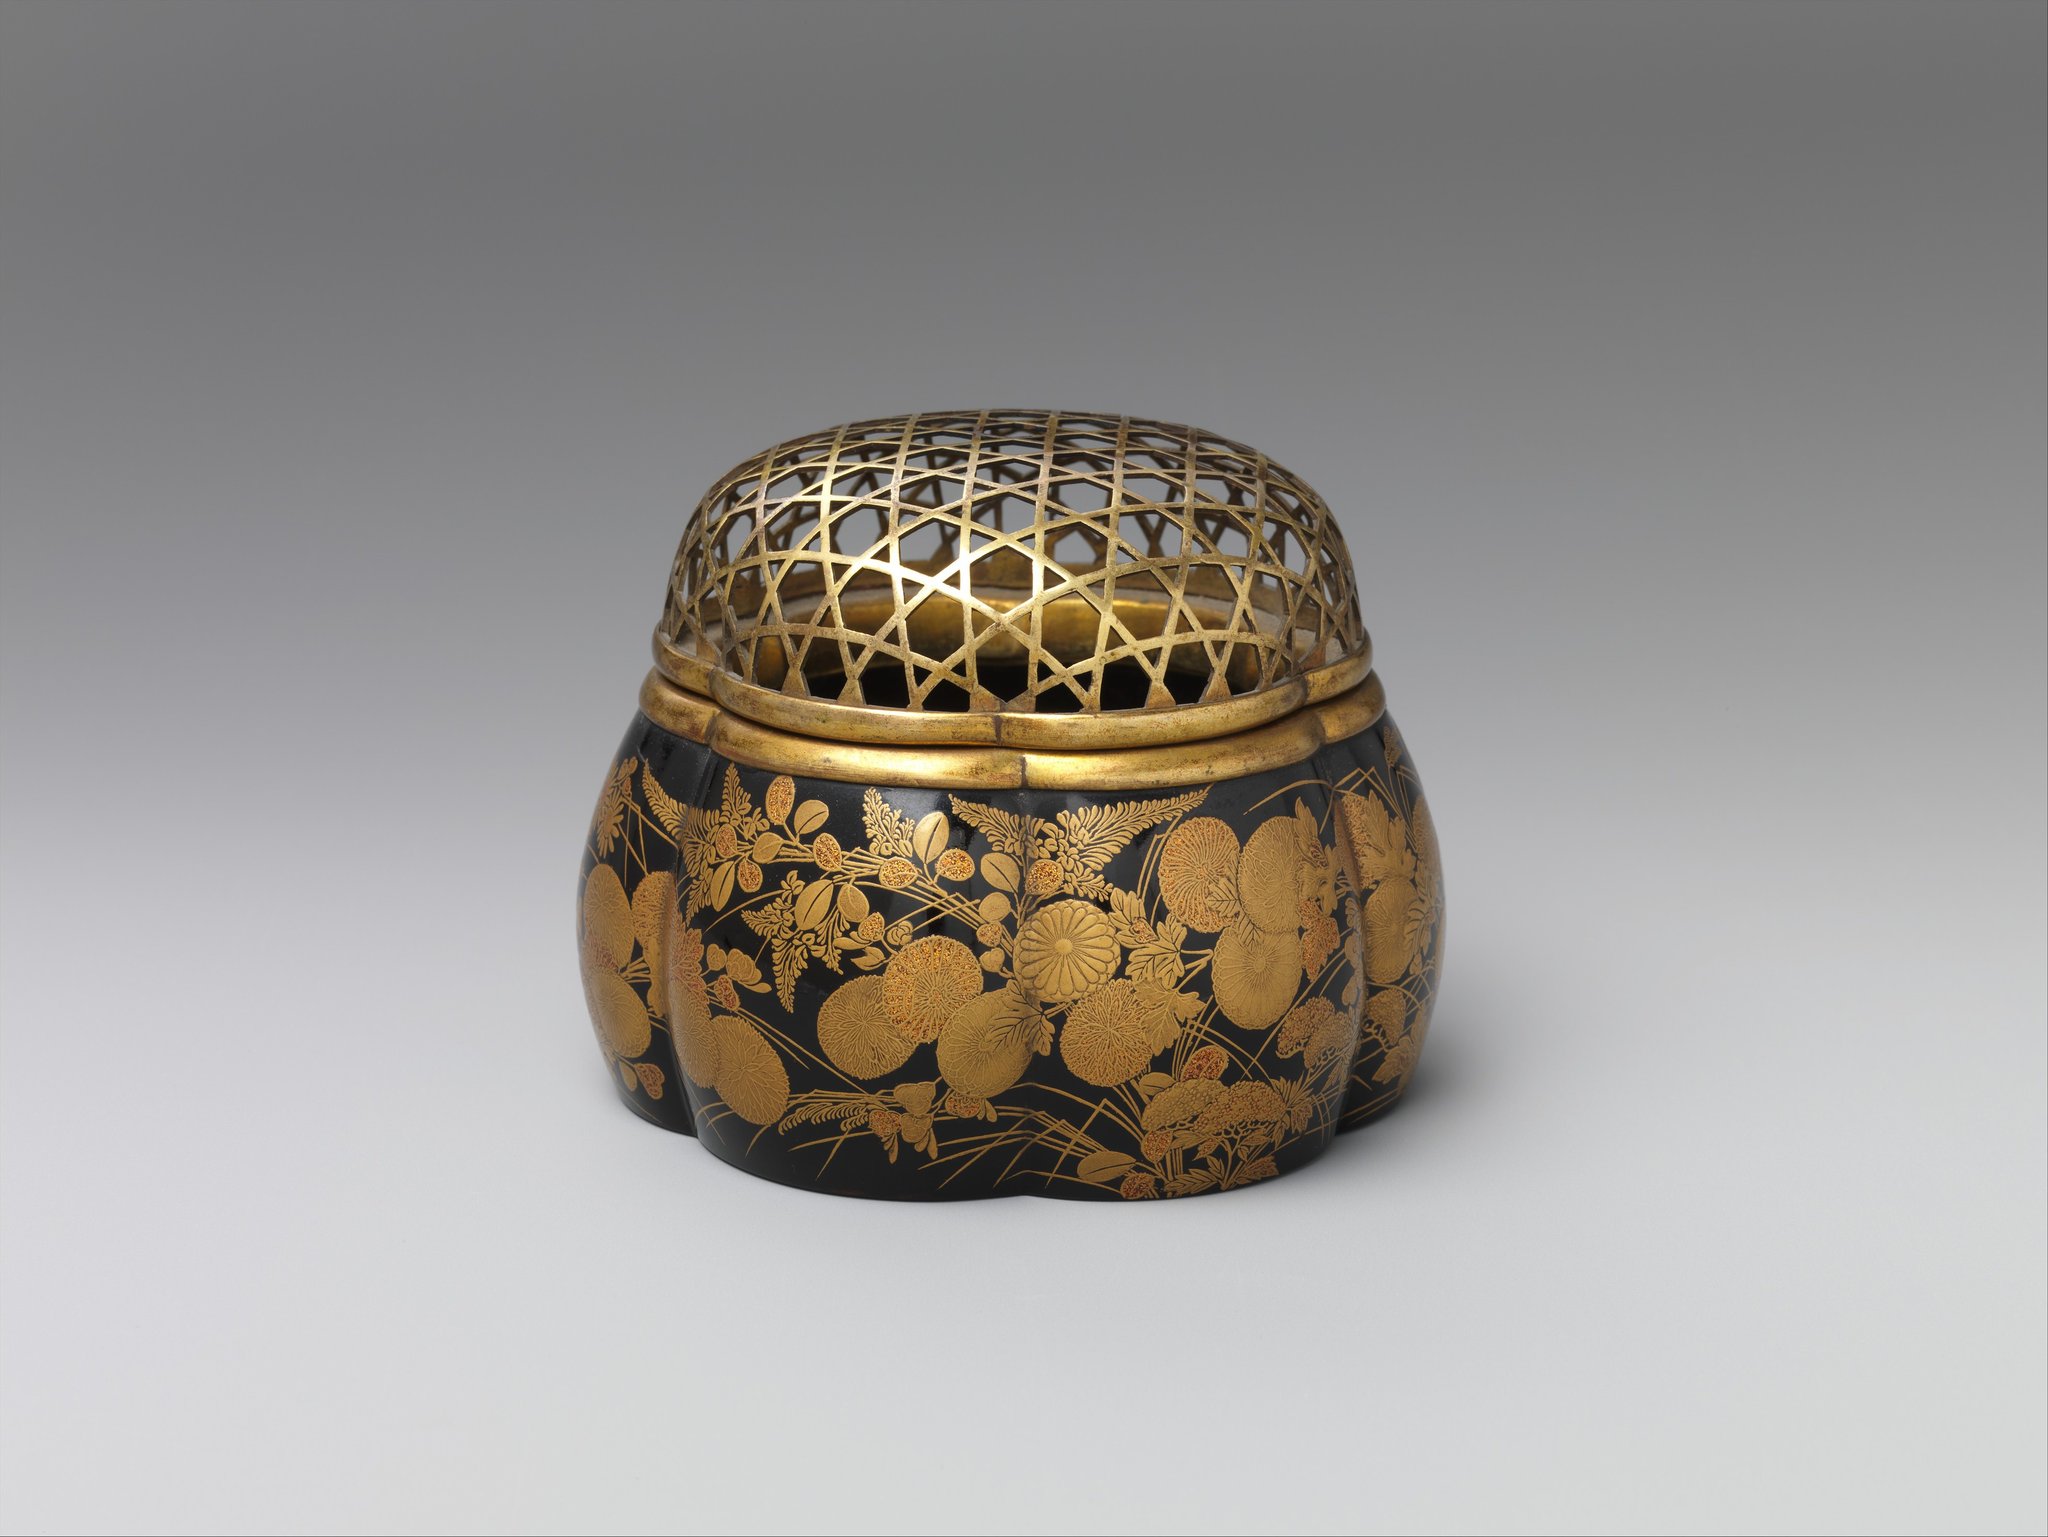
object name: incense burner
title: Incense Burner in the Shape of a Melon with Autumn Flowers and Grasses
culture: japanese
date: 1601-1633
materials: gilt bronze, gold, lacquer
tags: flowers